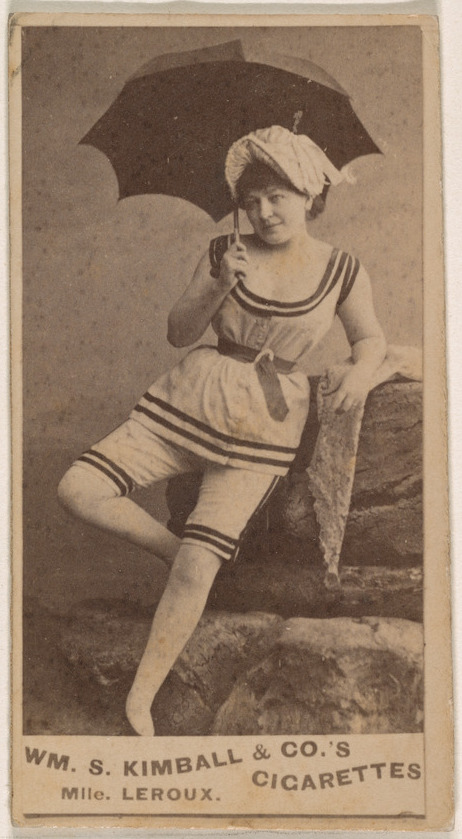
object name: photograph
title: Mlle. Leroux, from the Actresses series (N203) issued by Wm. S. Kimball & Co.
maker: william s. kimball & company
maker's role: publisher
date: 1889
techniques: color lithograph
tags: portraits,women,actresses